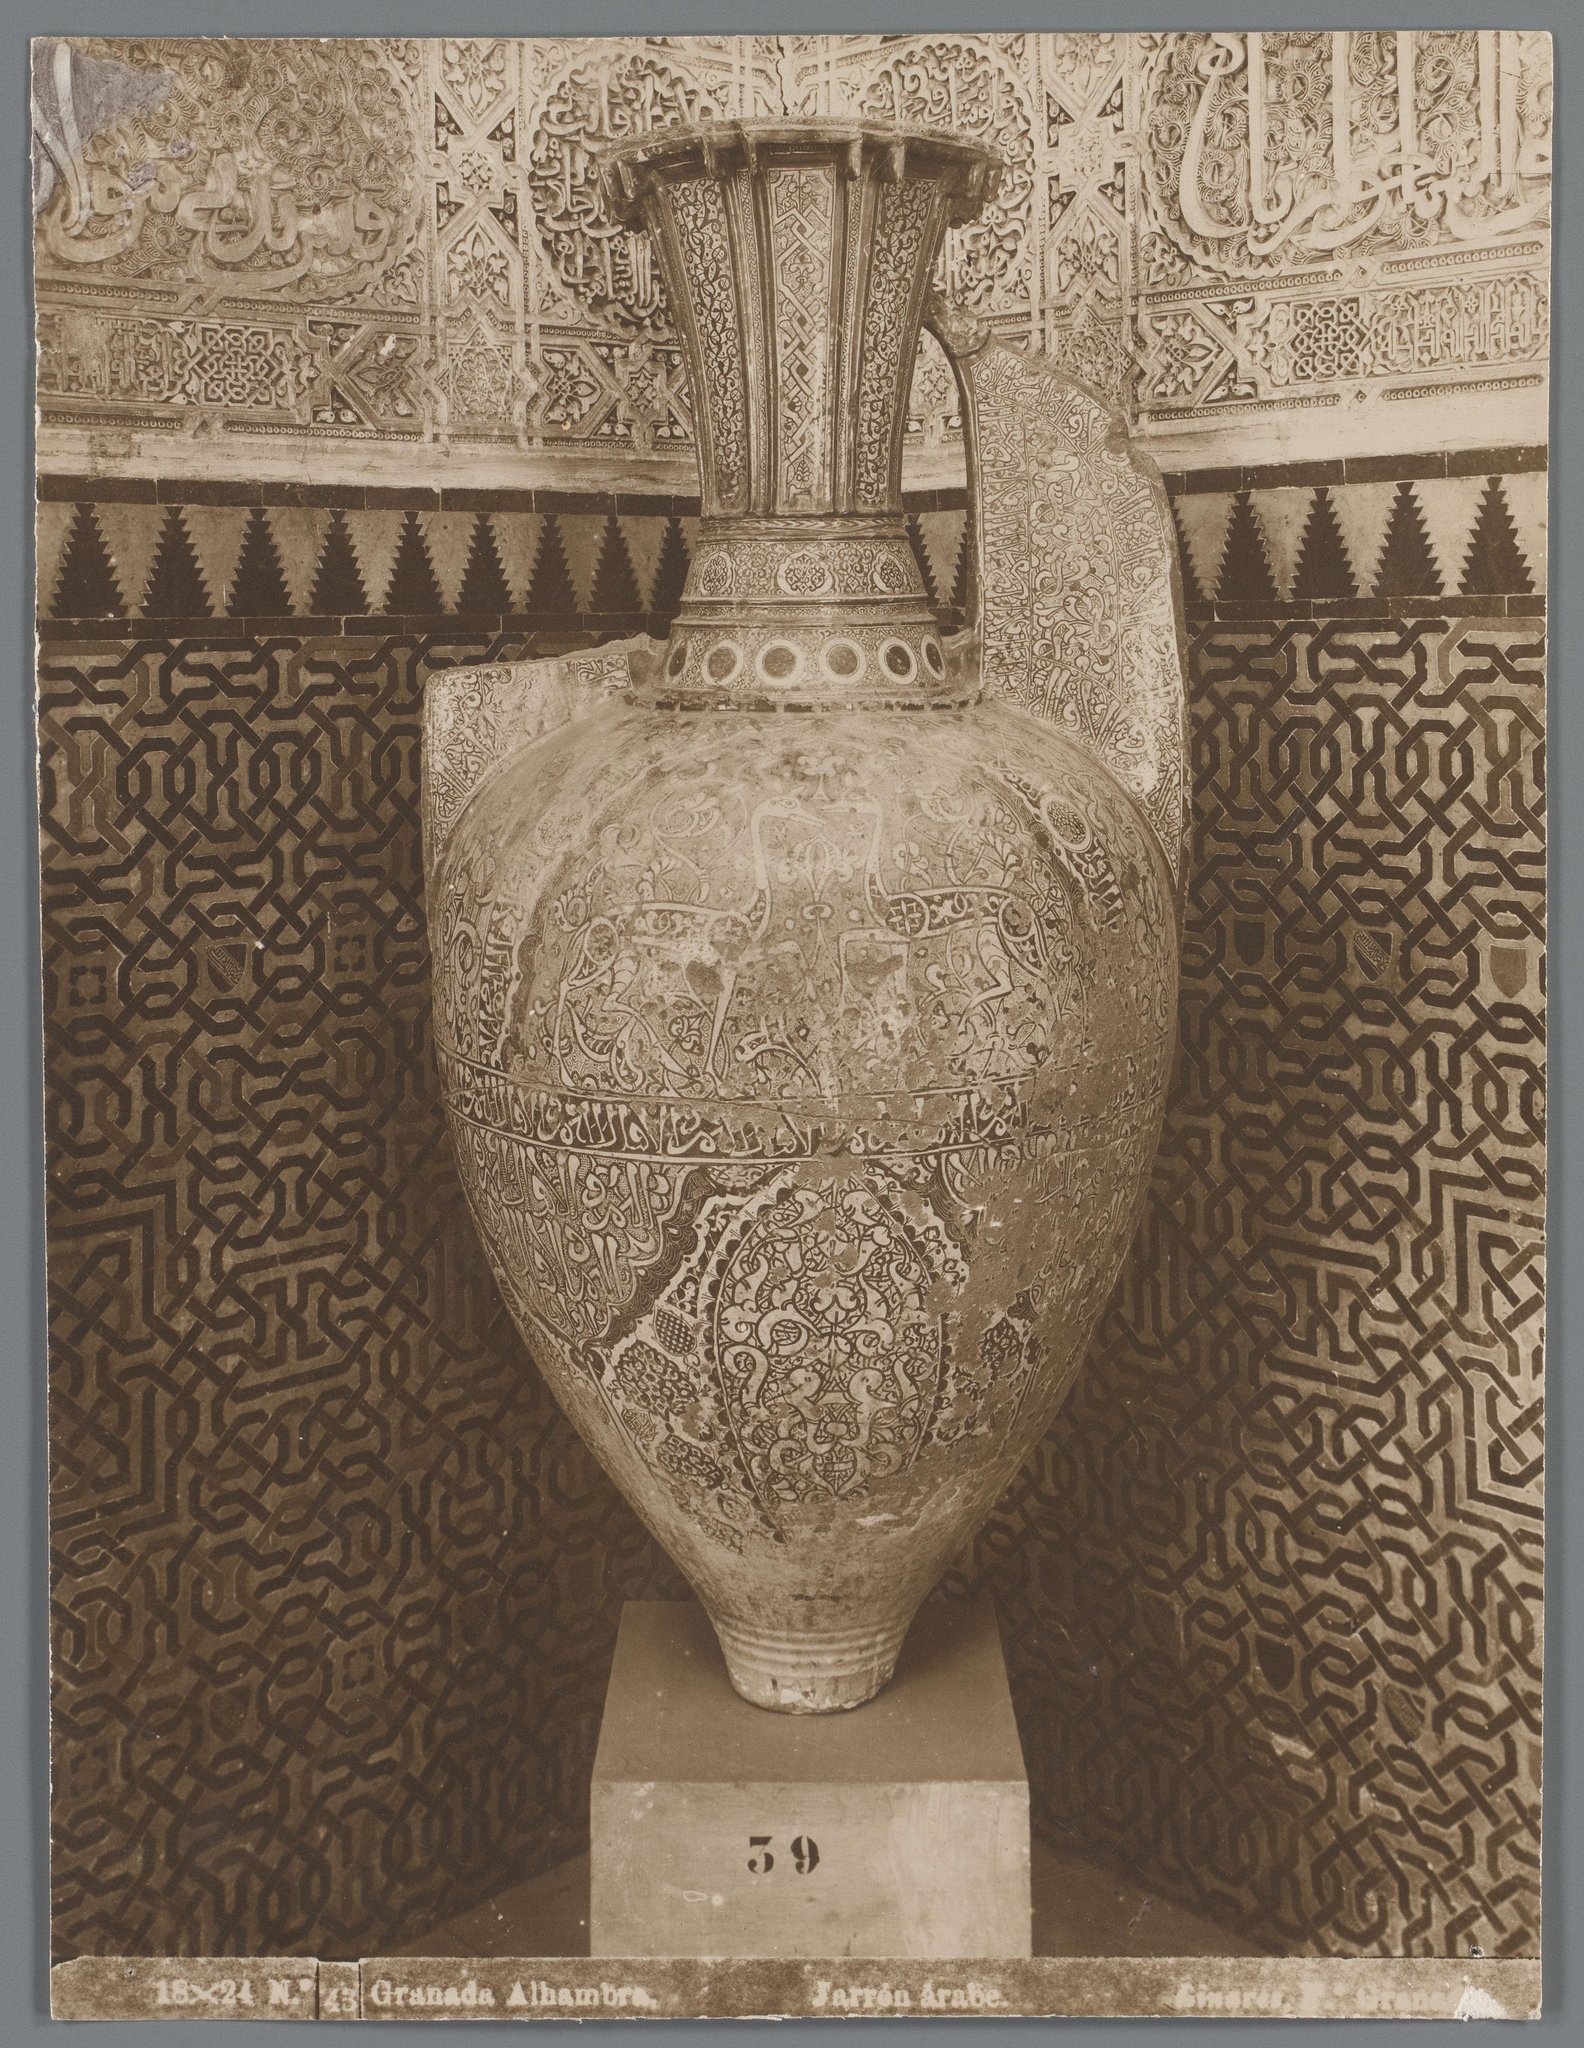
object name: photograph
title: Jarrén arabe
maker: f. linares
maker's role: publisher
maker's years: 1870-1937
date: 1914-1937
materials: photographic support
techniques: gelatin silver print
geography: alhambra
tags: container of stone: stone vase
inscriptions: inscription: ‘18 x 24’, number: ‘No. 43’